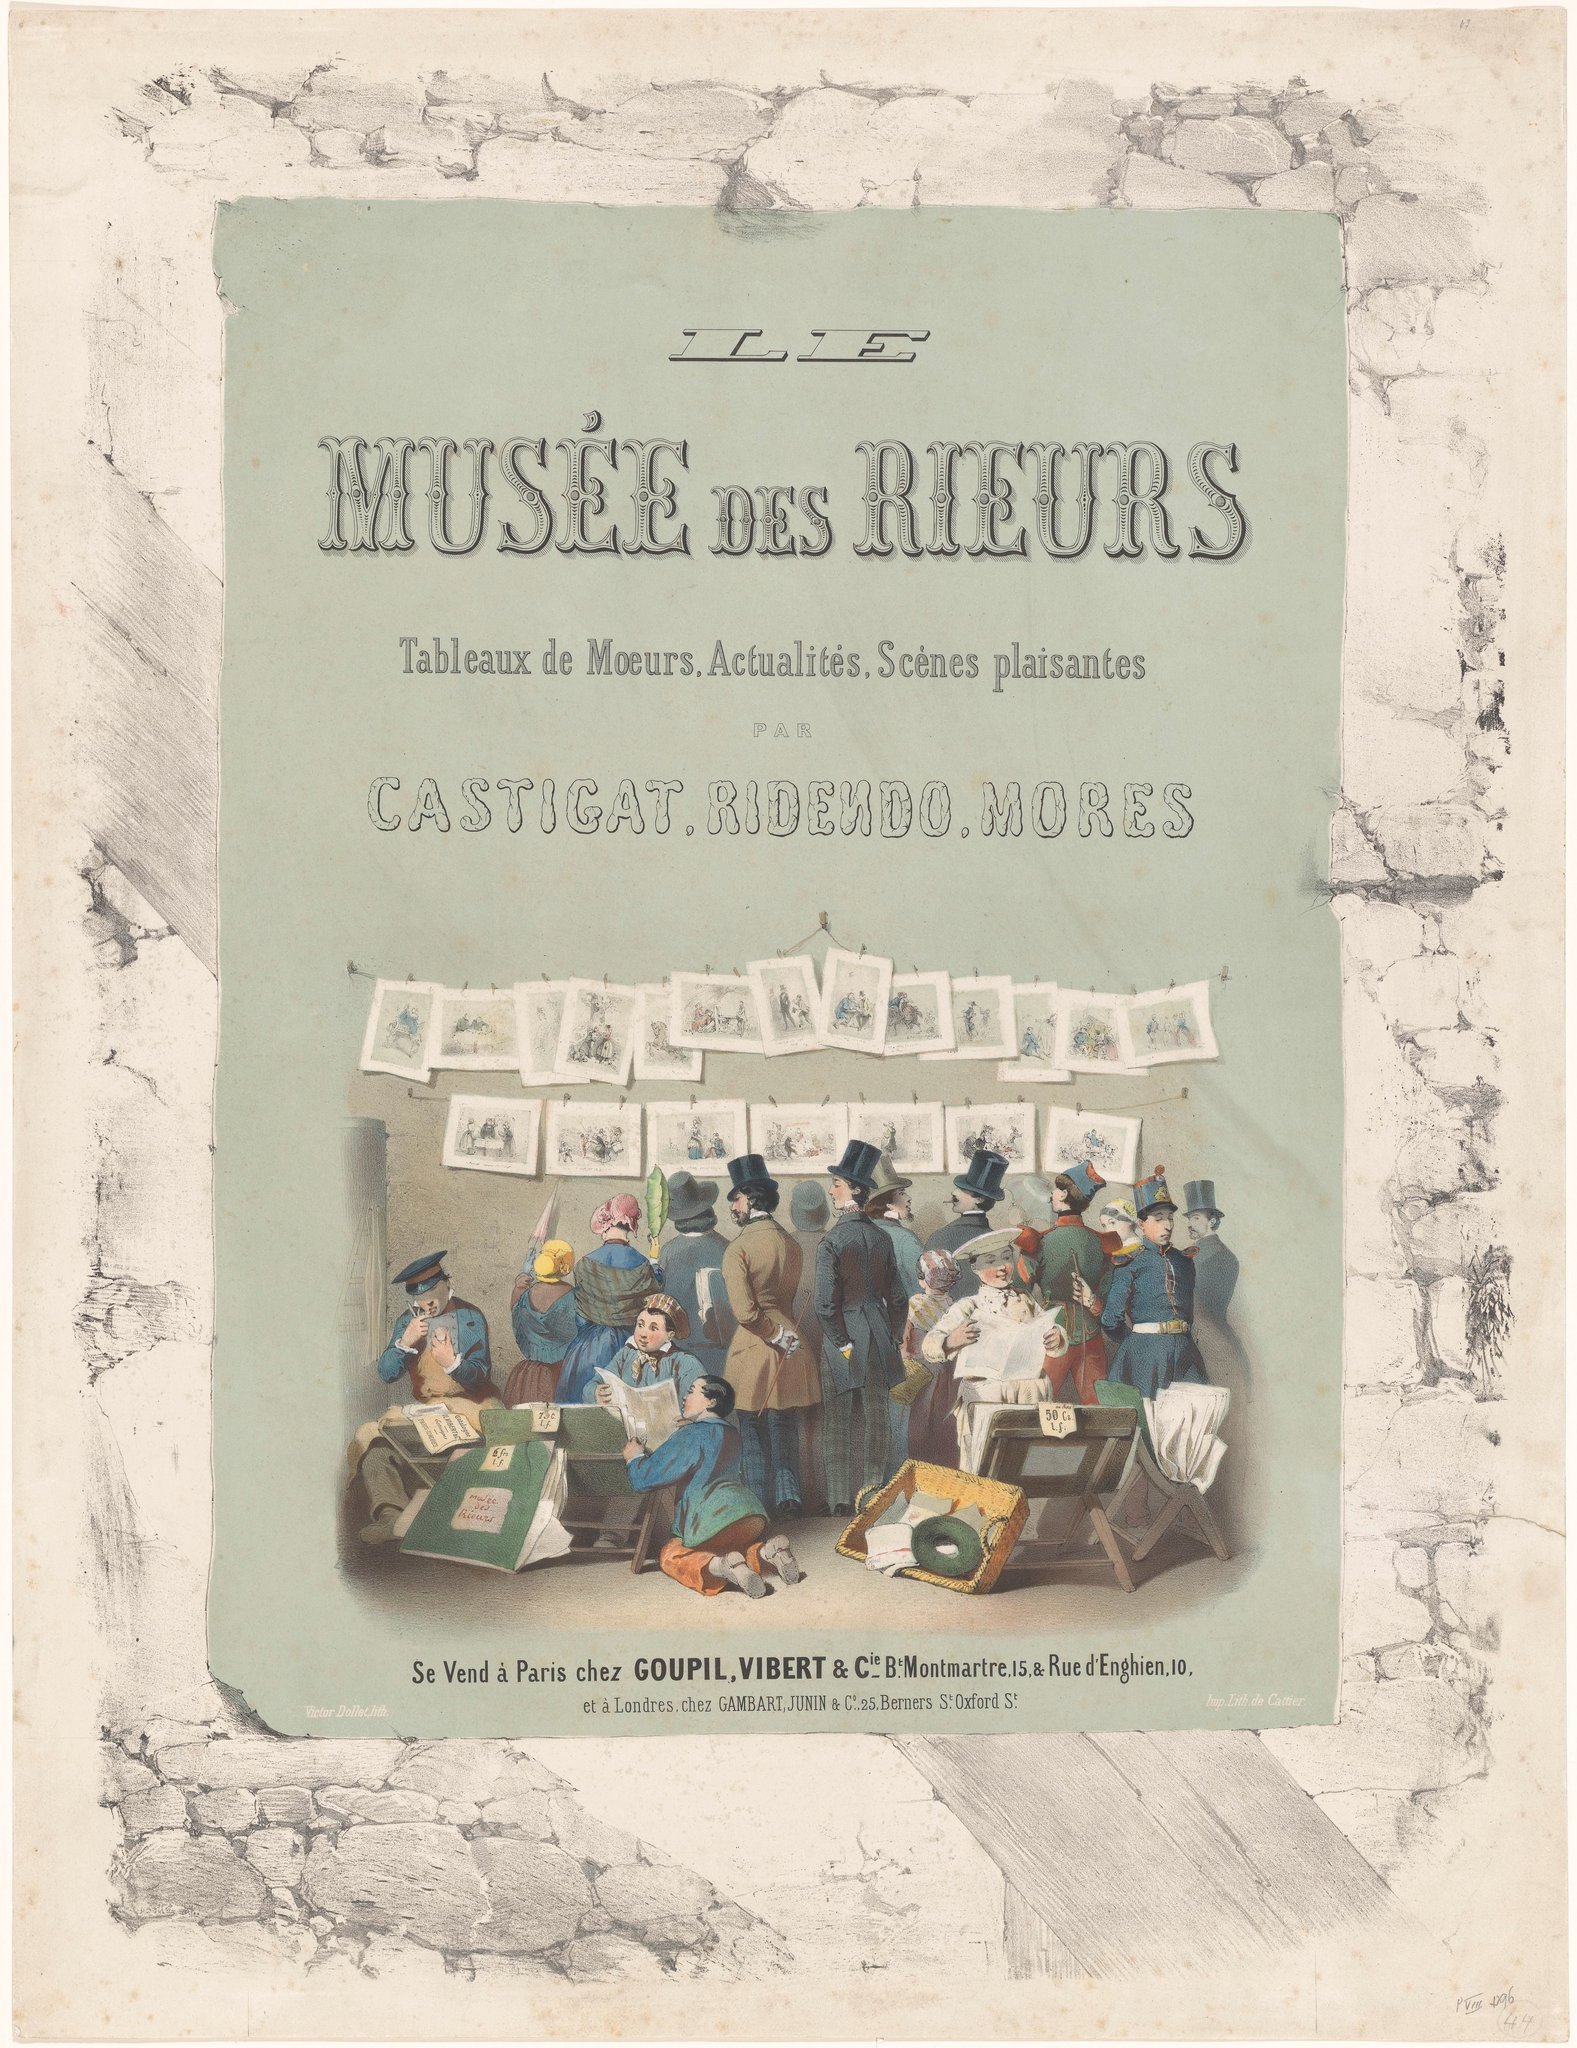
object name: print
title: Affiche voor de prentserie Le Musée des Rieurs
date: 1847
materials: paper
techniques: hand coloring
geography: paris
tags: private soldier, print, e.g.: engraving, etching, lithograph, art dealer (+ graphic arts), street-trader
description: Aanplakbiljet bevestigd tegen een stenen muur met daarop mannen, vrouwen en kinderen die het aanbod van een prentverkoper bekijken. Een deel van de prenten is opgehangen aan een koord tegen de muur, de rest wordt bewaard in mappen.